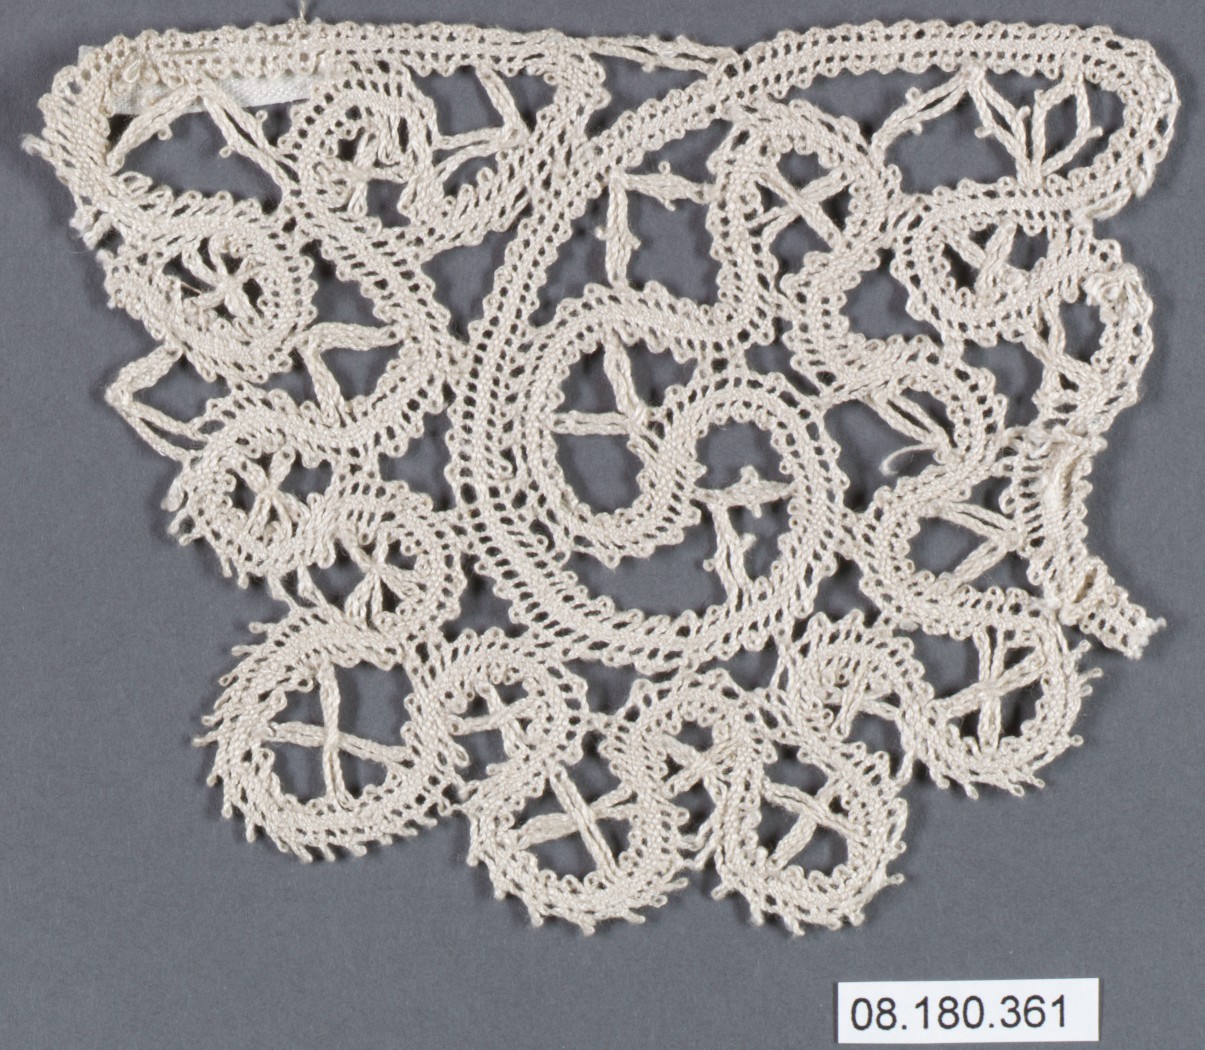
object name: fragment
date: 1801-1900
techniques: lace